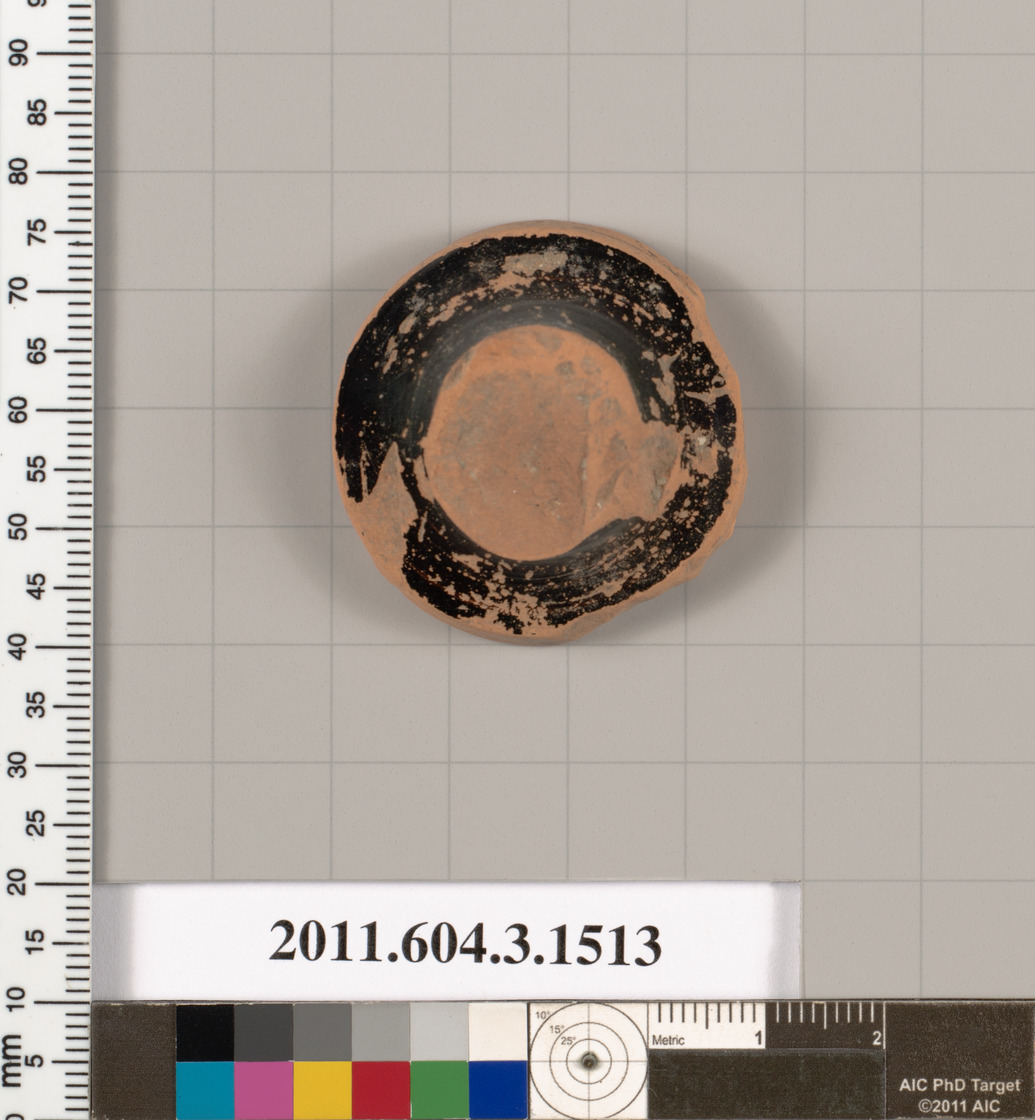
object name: lekythos fragment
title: Terracotta fragment of a lekythos (oil flask)?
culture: greek, attic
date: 600-401 BCE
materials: terracotta